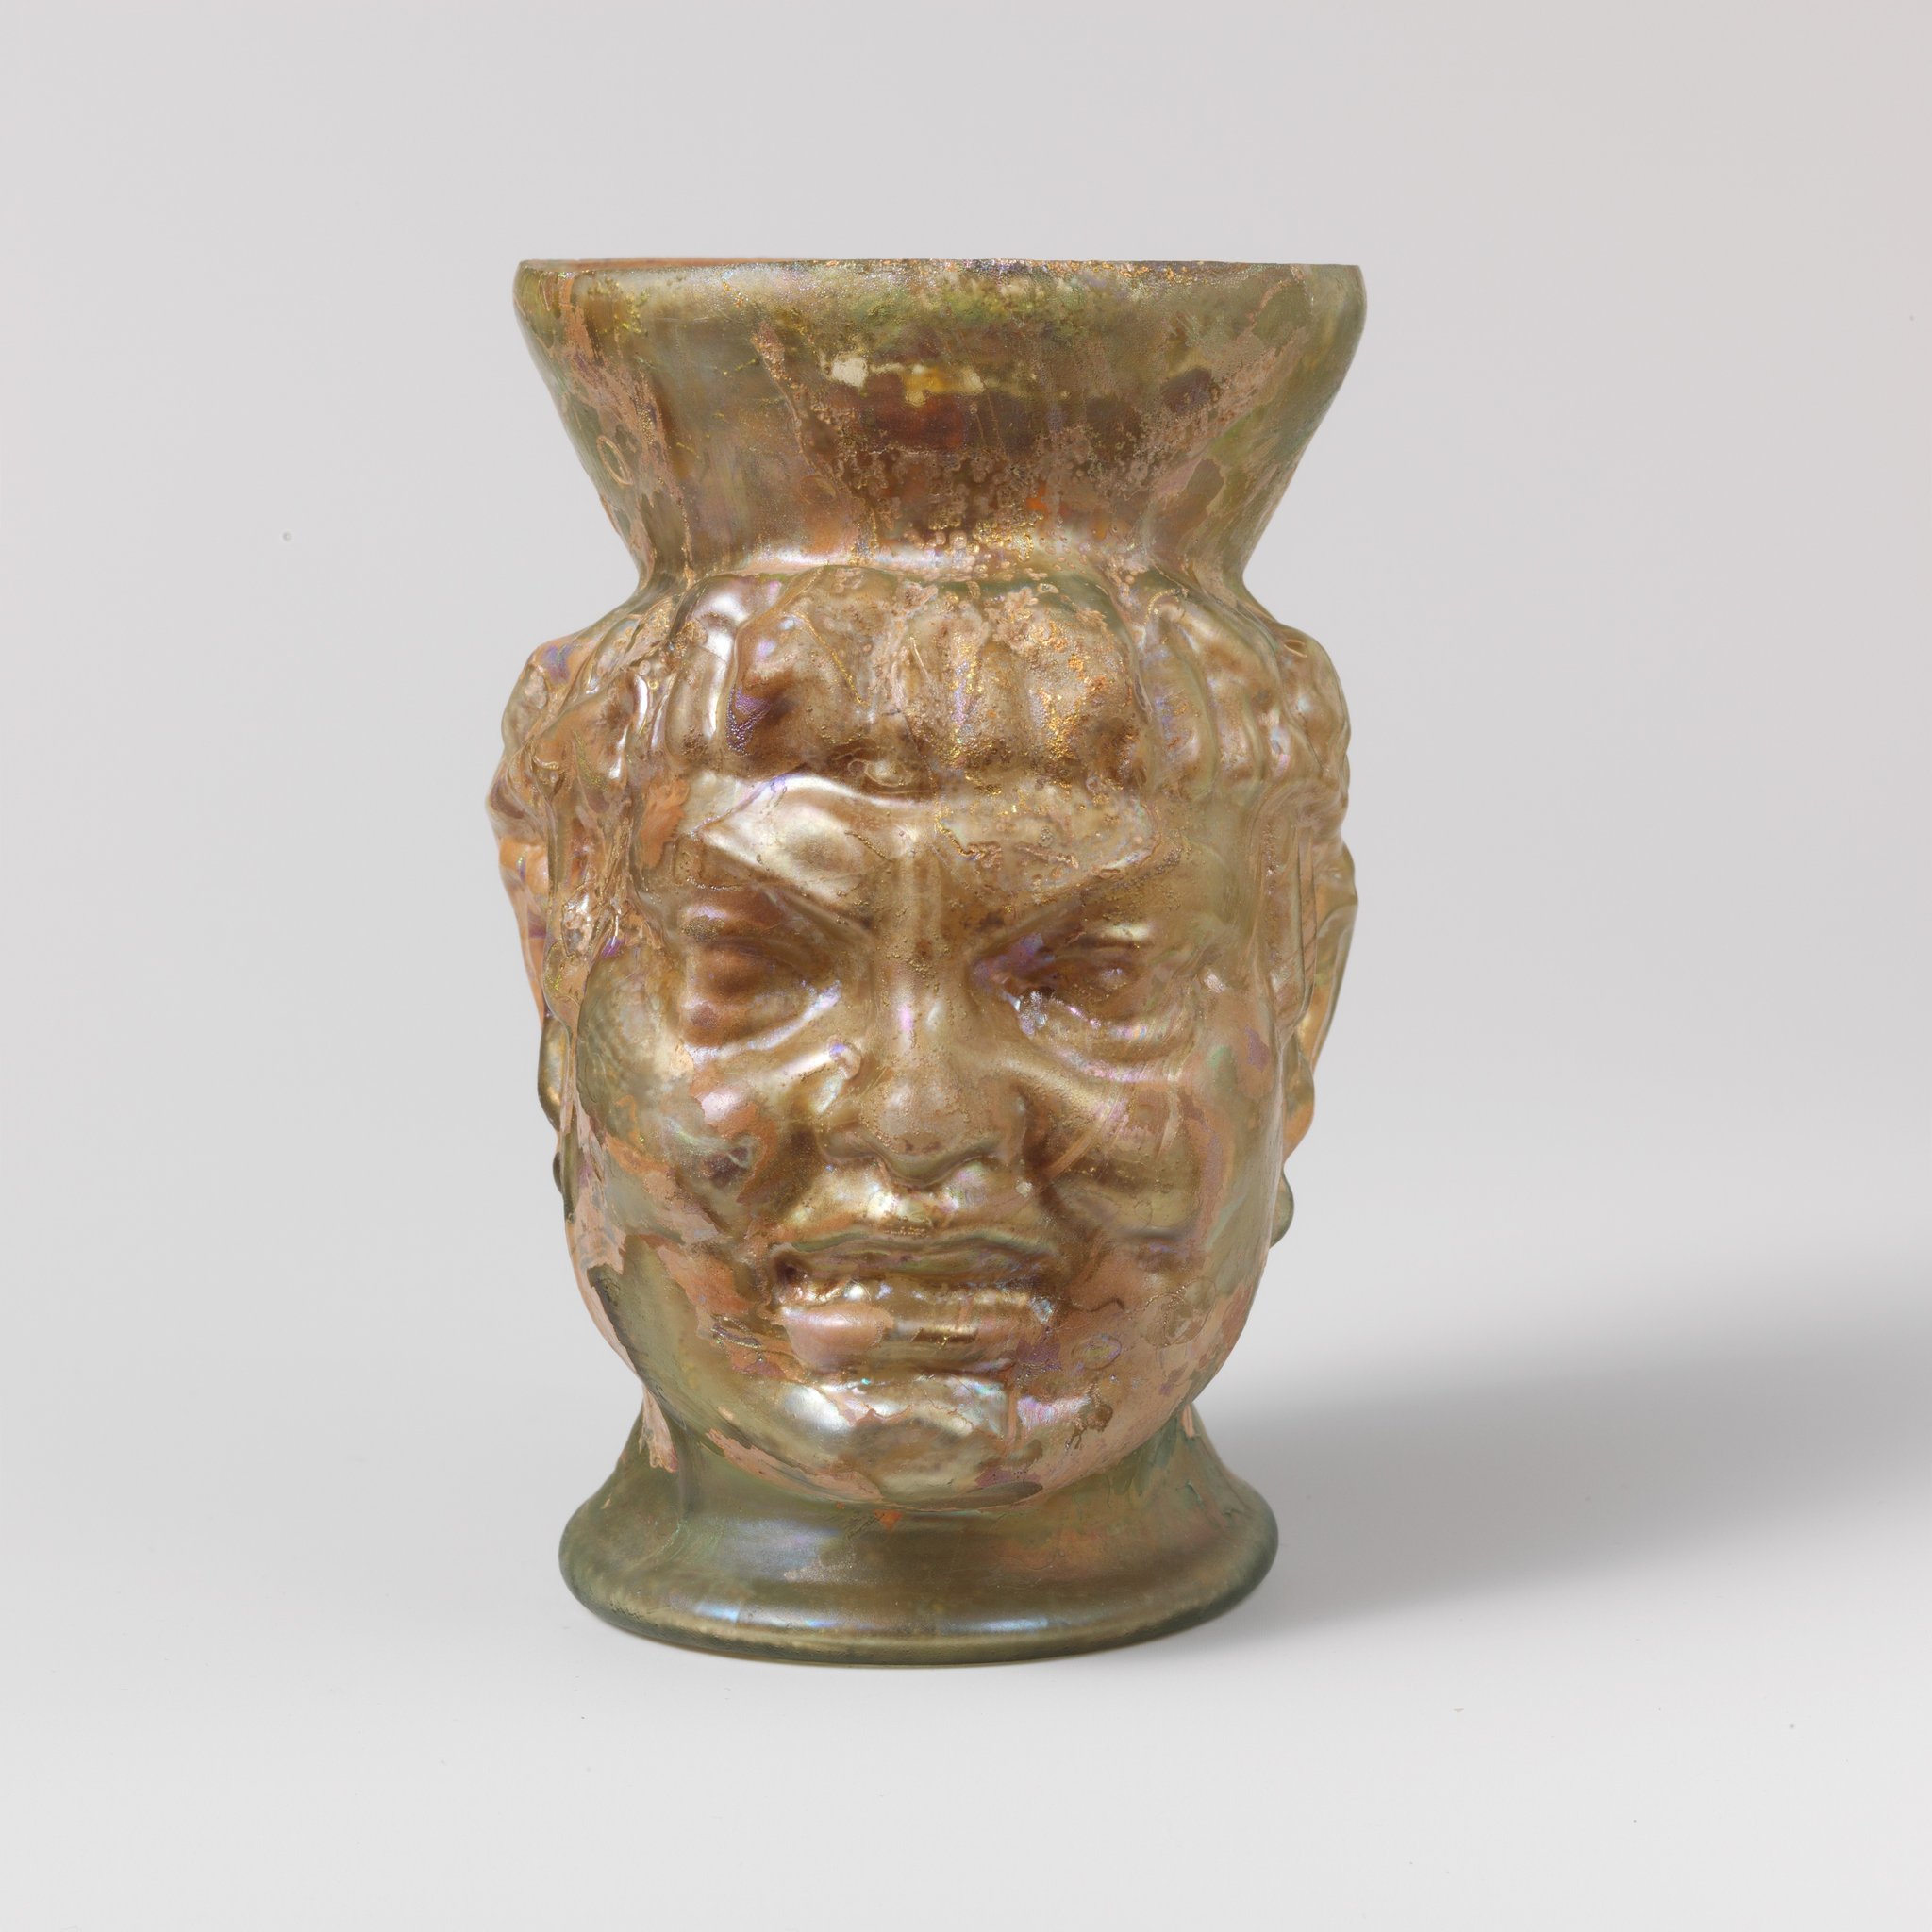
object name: cup in the form of a head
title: Glass cup in the shape of a Black African's head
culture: roman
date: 51-100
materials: glass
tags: heads